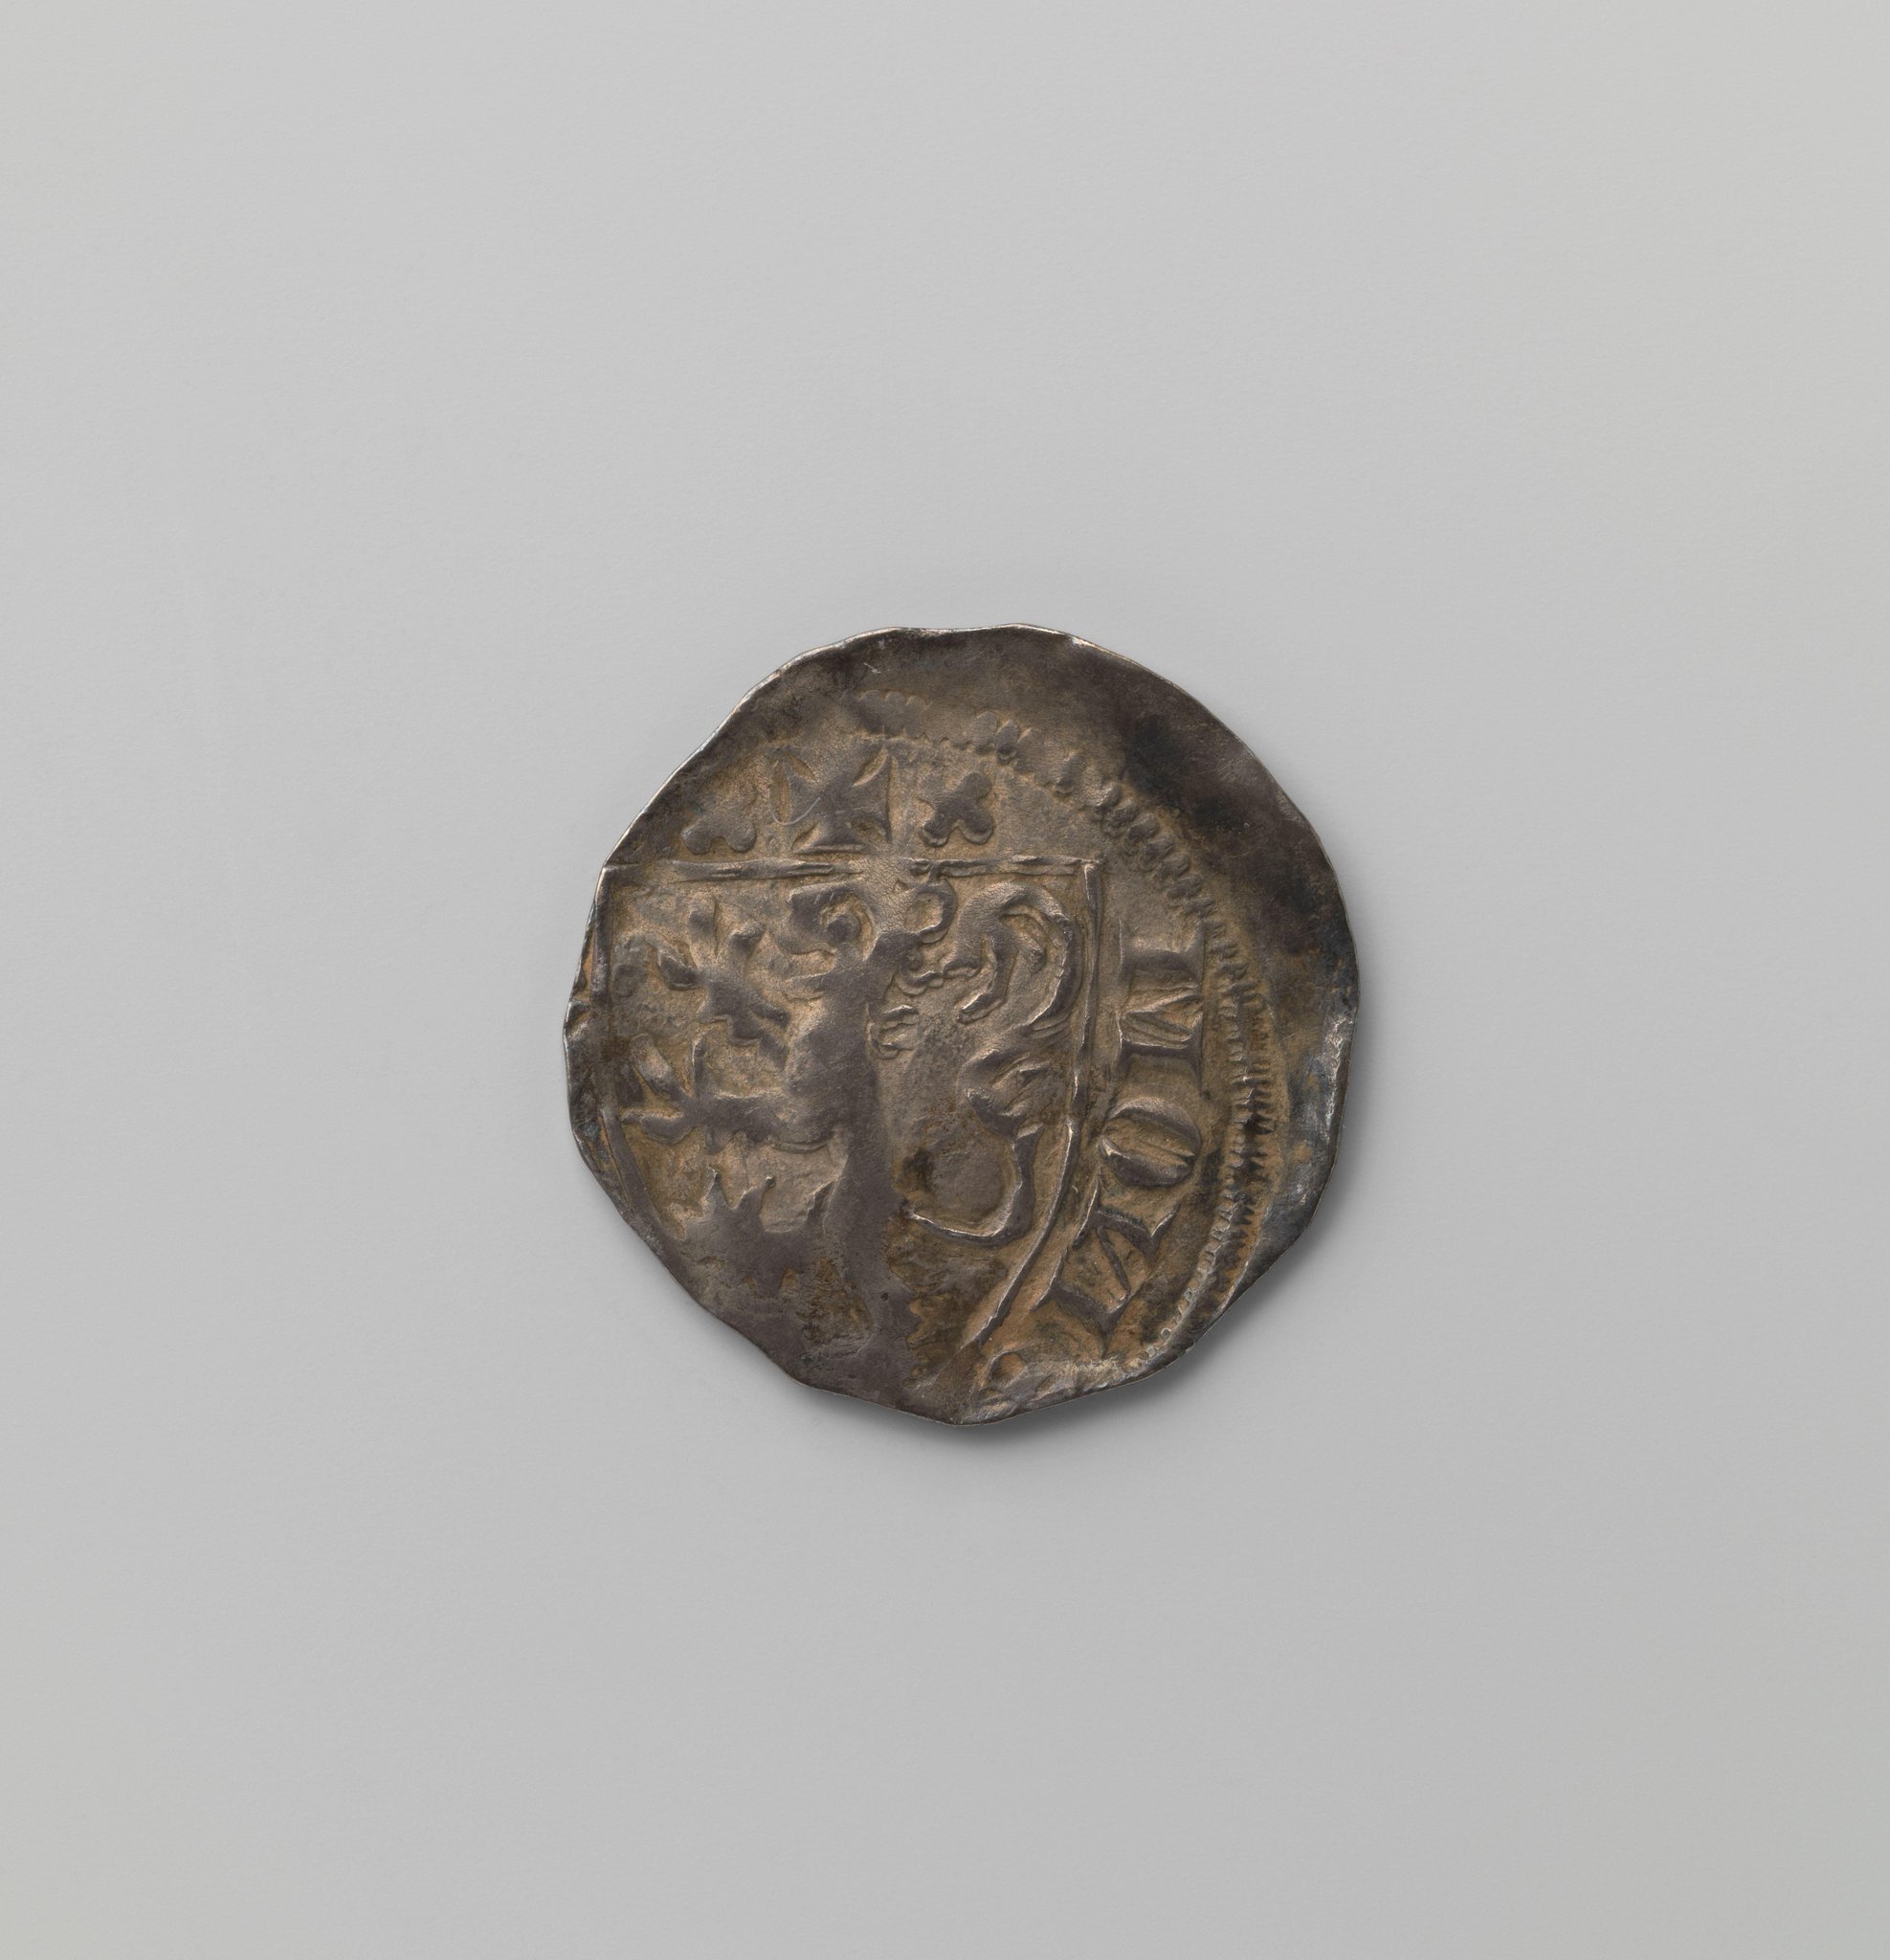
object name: coin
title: Sterling uit Brabant van Jan I, 1268-1294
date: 1282-1294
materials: silver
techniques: striking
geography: maastricht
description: Voorzijde: in een punt uitlopend Limburgs wapenschild, waaromheen omschrift. Keerzijde: lang dubbellijnig kruis, in de hoeken letters T,R,I en T. Daaromheen omschrift.